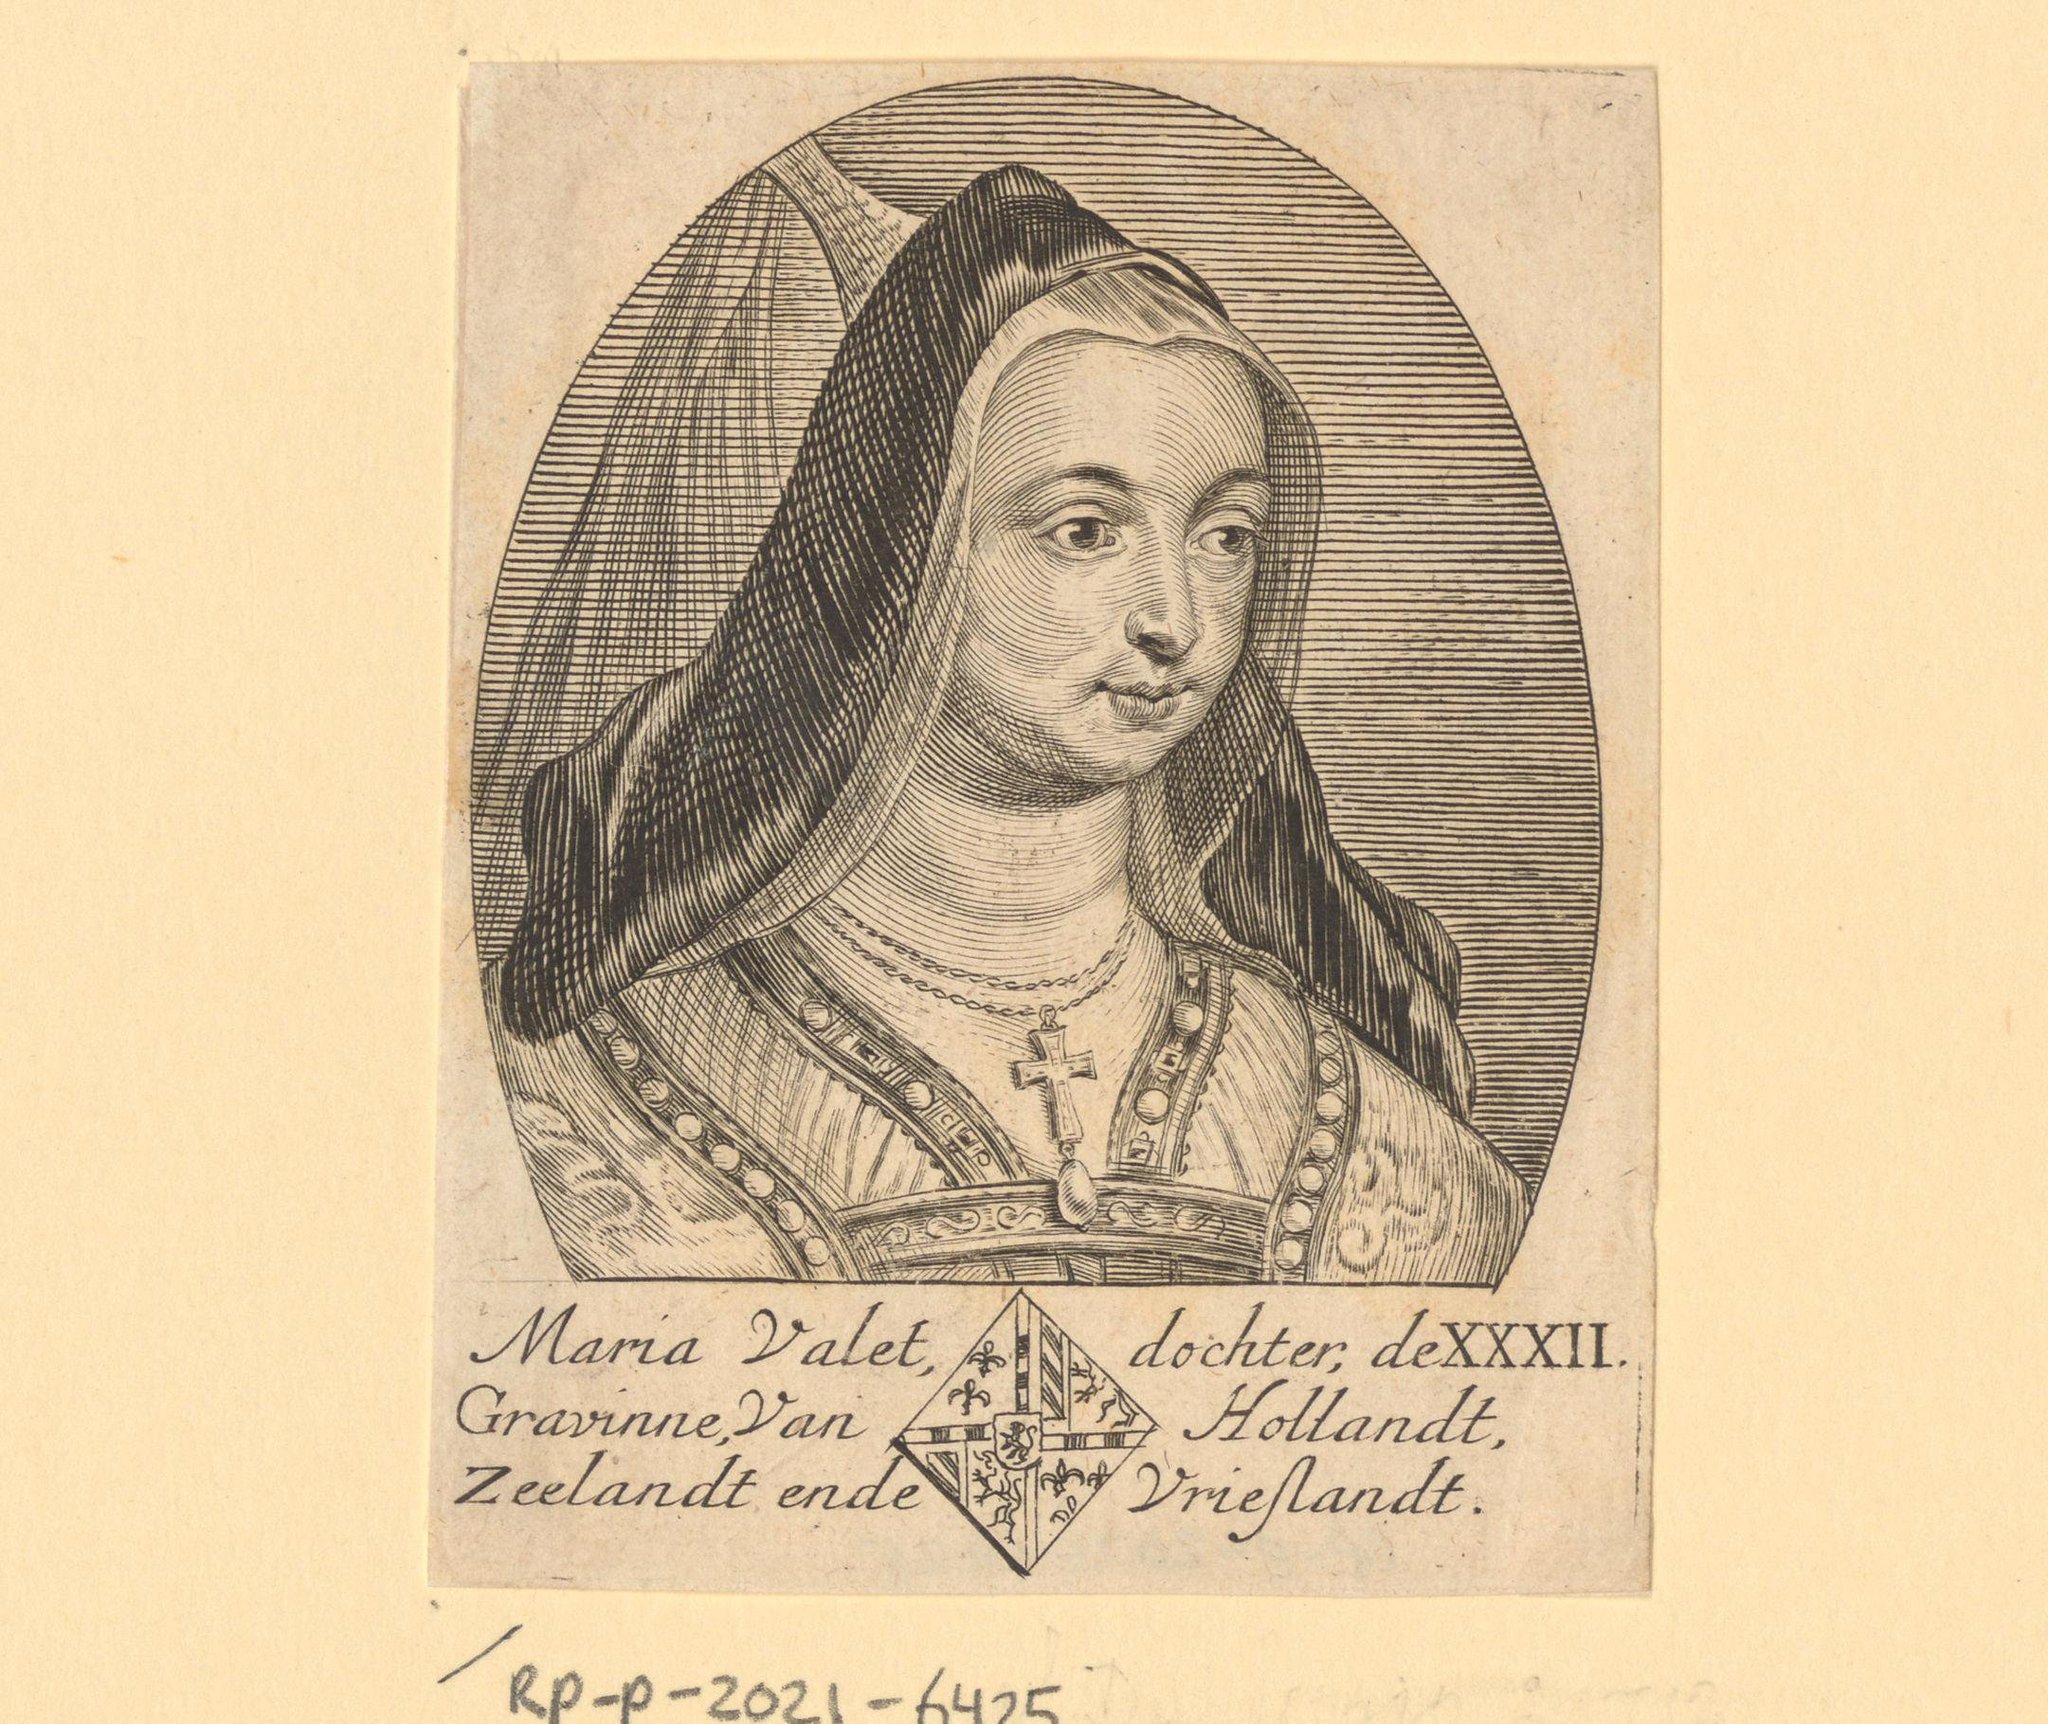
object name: book illustration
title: Portret van Maria van Bourgondië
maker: Anonymous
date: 1678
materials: paper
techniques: engraving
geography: northern netherlands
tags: brussels, bruges, maria (hertogin van bourgondië), historical persons - bb - woman, pearl; pearl necklace, armorial bearing, heraldry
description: Prent waarschijnlijk uit: Scriverius, Petrus. Beschryvinge van alle de Graven van Holland, Zeeland ende West-Vrieslandt (...). Den Haag: Johannes Tongerloo et al., 1678, dl. 2, p. 441.